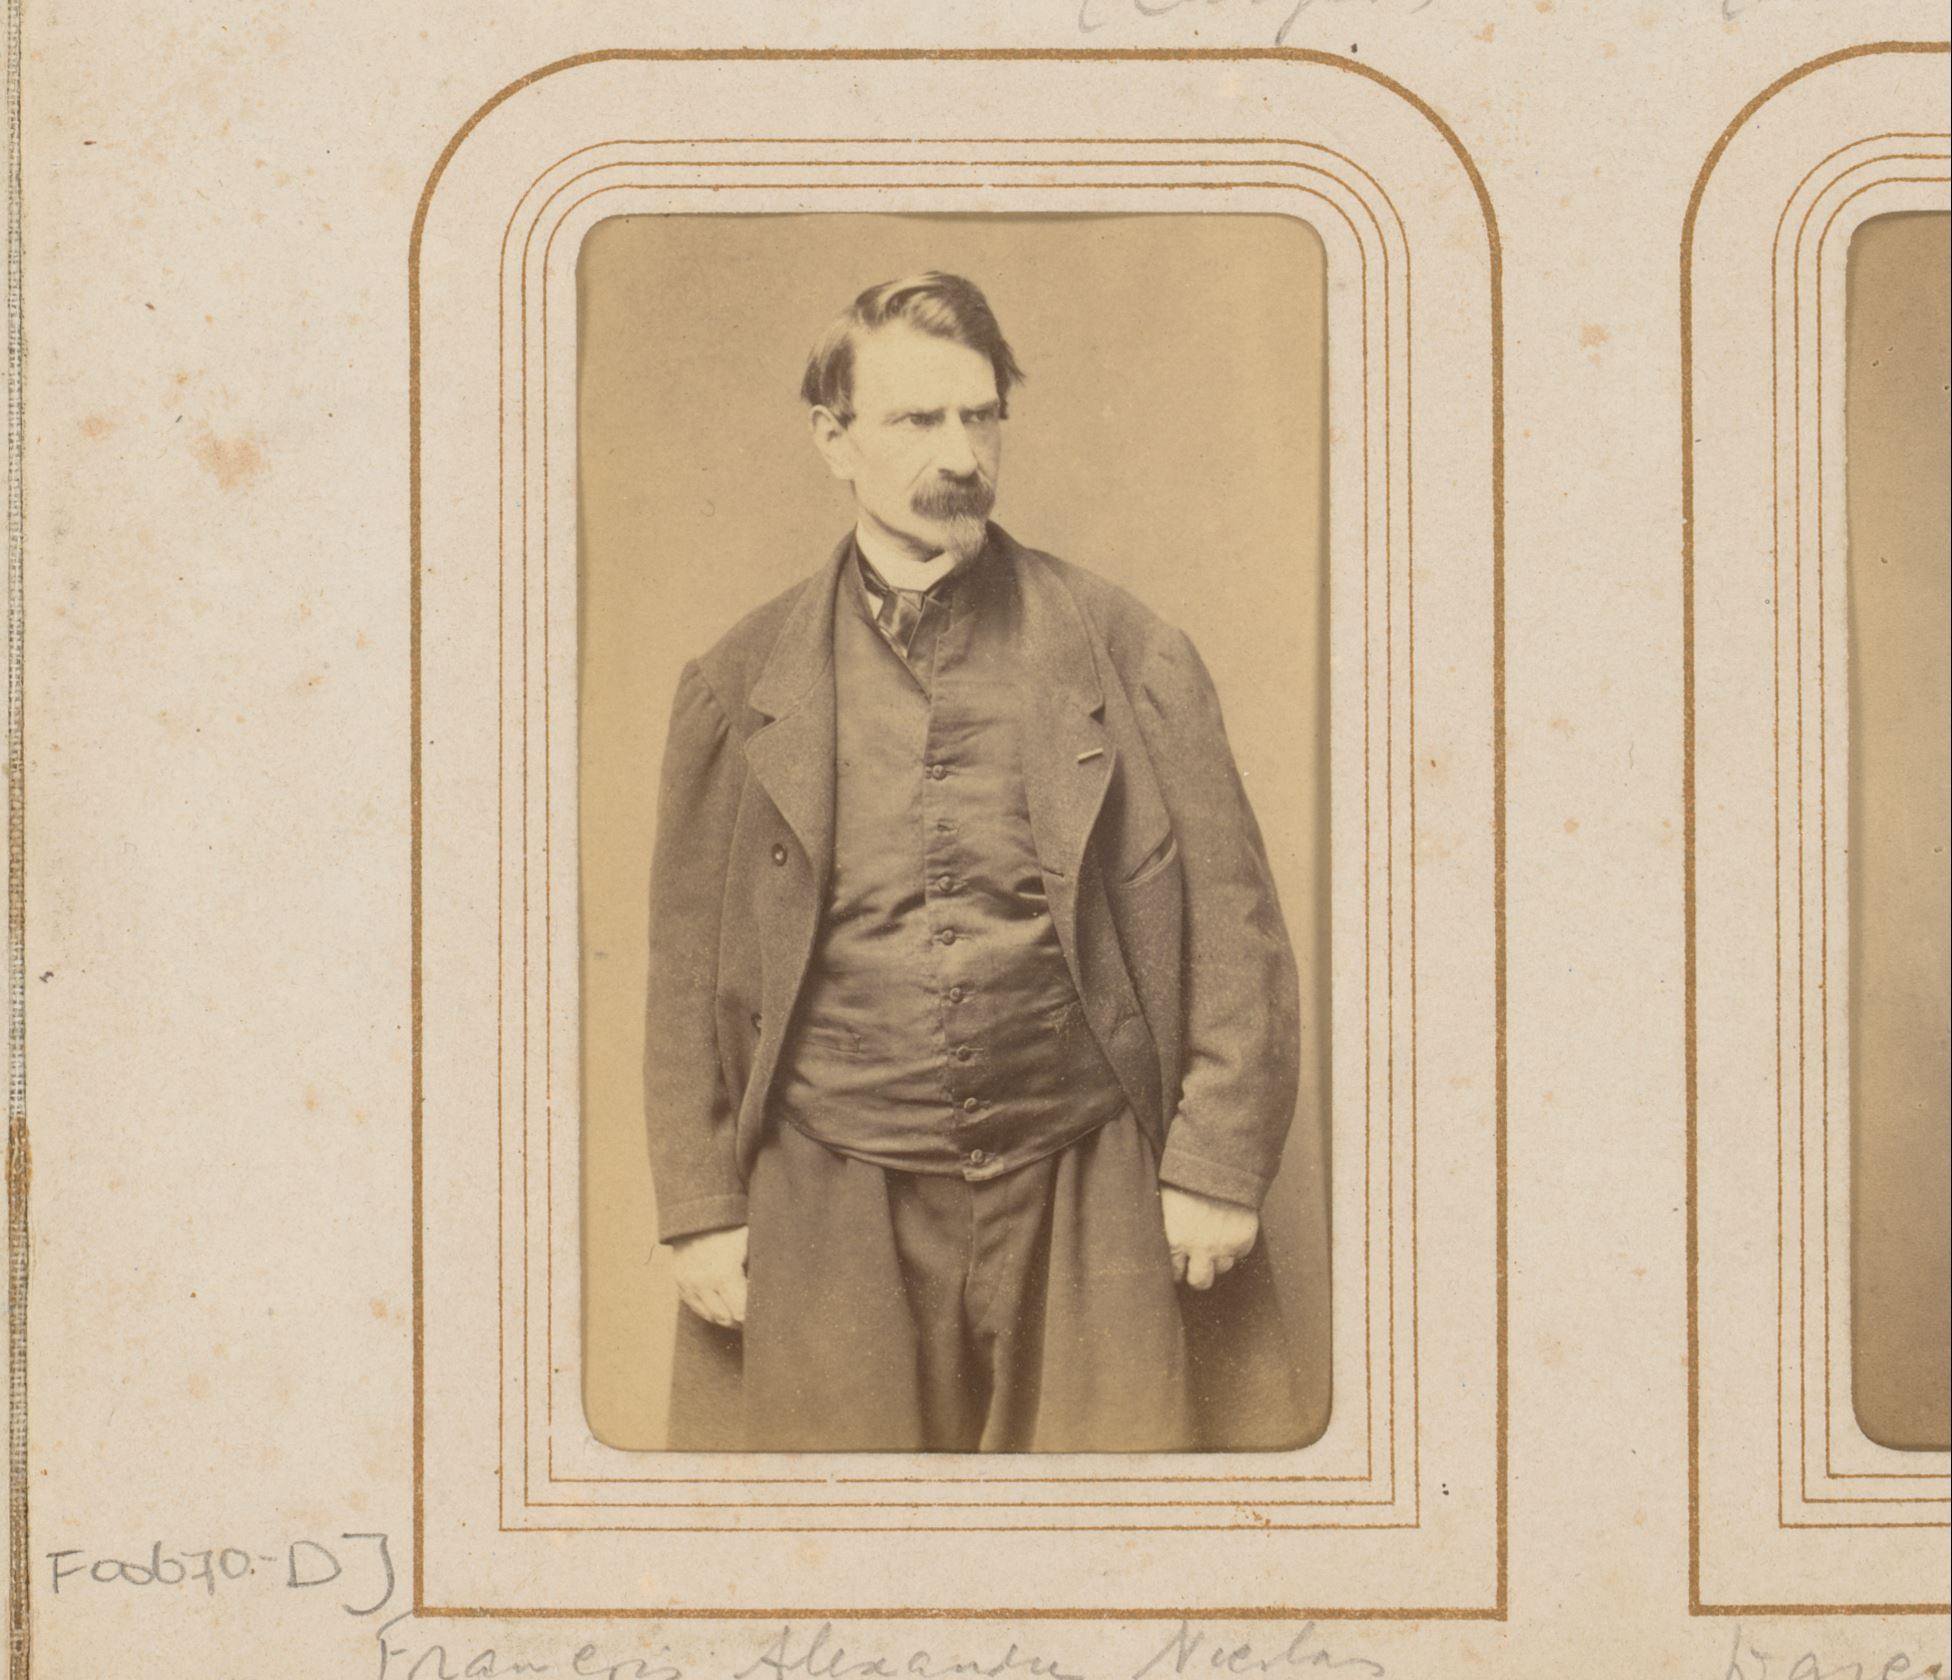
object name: photograph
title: Portret van François Delsarte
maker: étienne carjat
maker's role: draughtsman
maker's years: 1828-1906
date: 1861-1867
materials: cardboard, photographic support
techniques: albumen print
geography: paris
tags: paris, historical persons, portrait of actor, actress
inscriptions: inscription: ‘Photographie/ Carjat & Cie/ 56, Rue Laffitte (...)’, annotation: ‘François Alexandre Nicolas Chéri Delsarte fr. actuer en zanager 1811-1871 (Carjat)’, name: ‘François Delsirte’